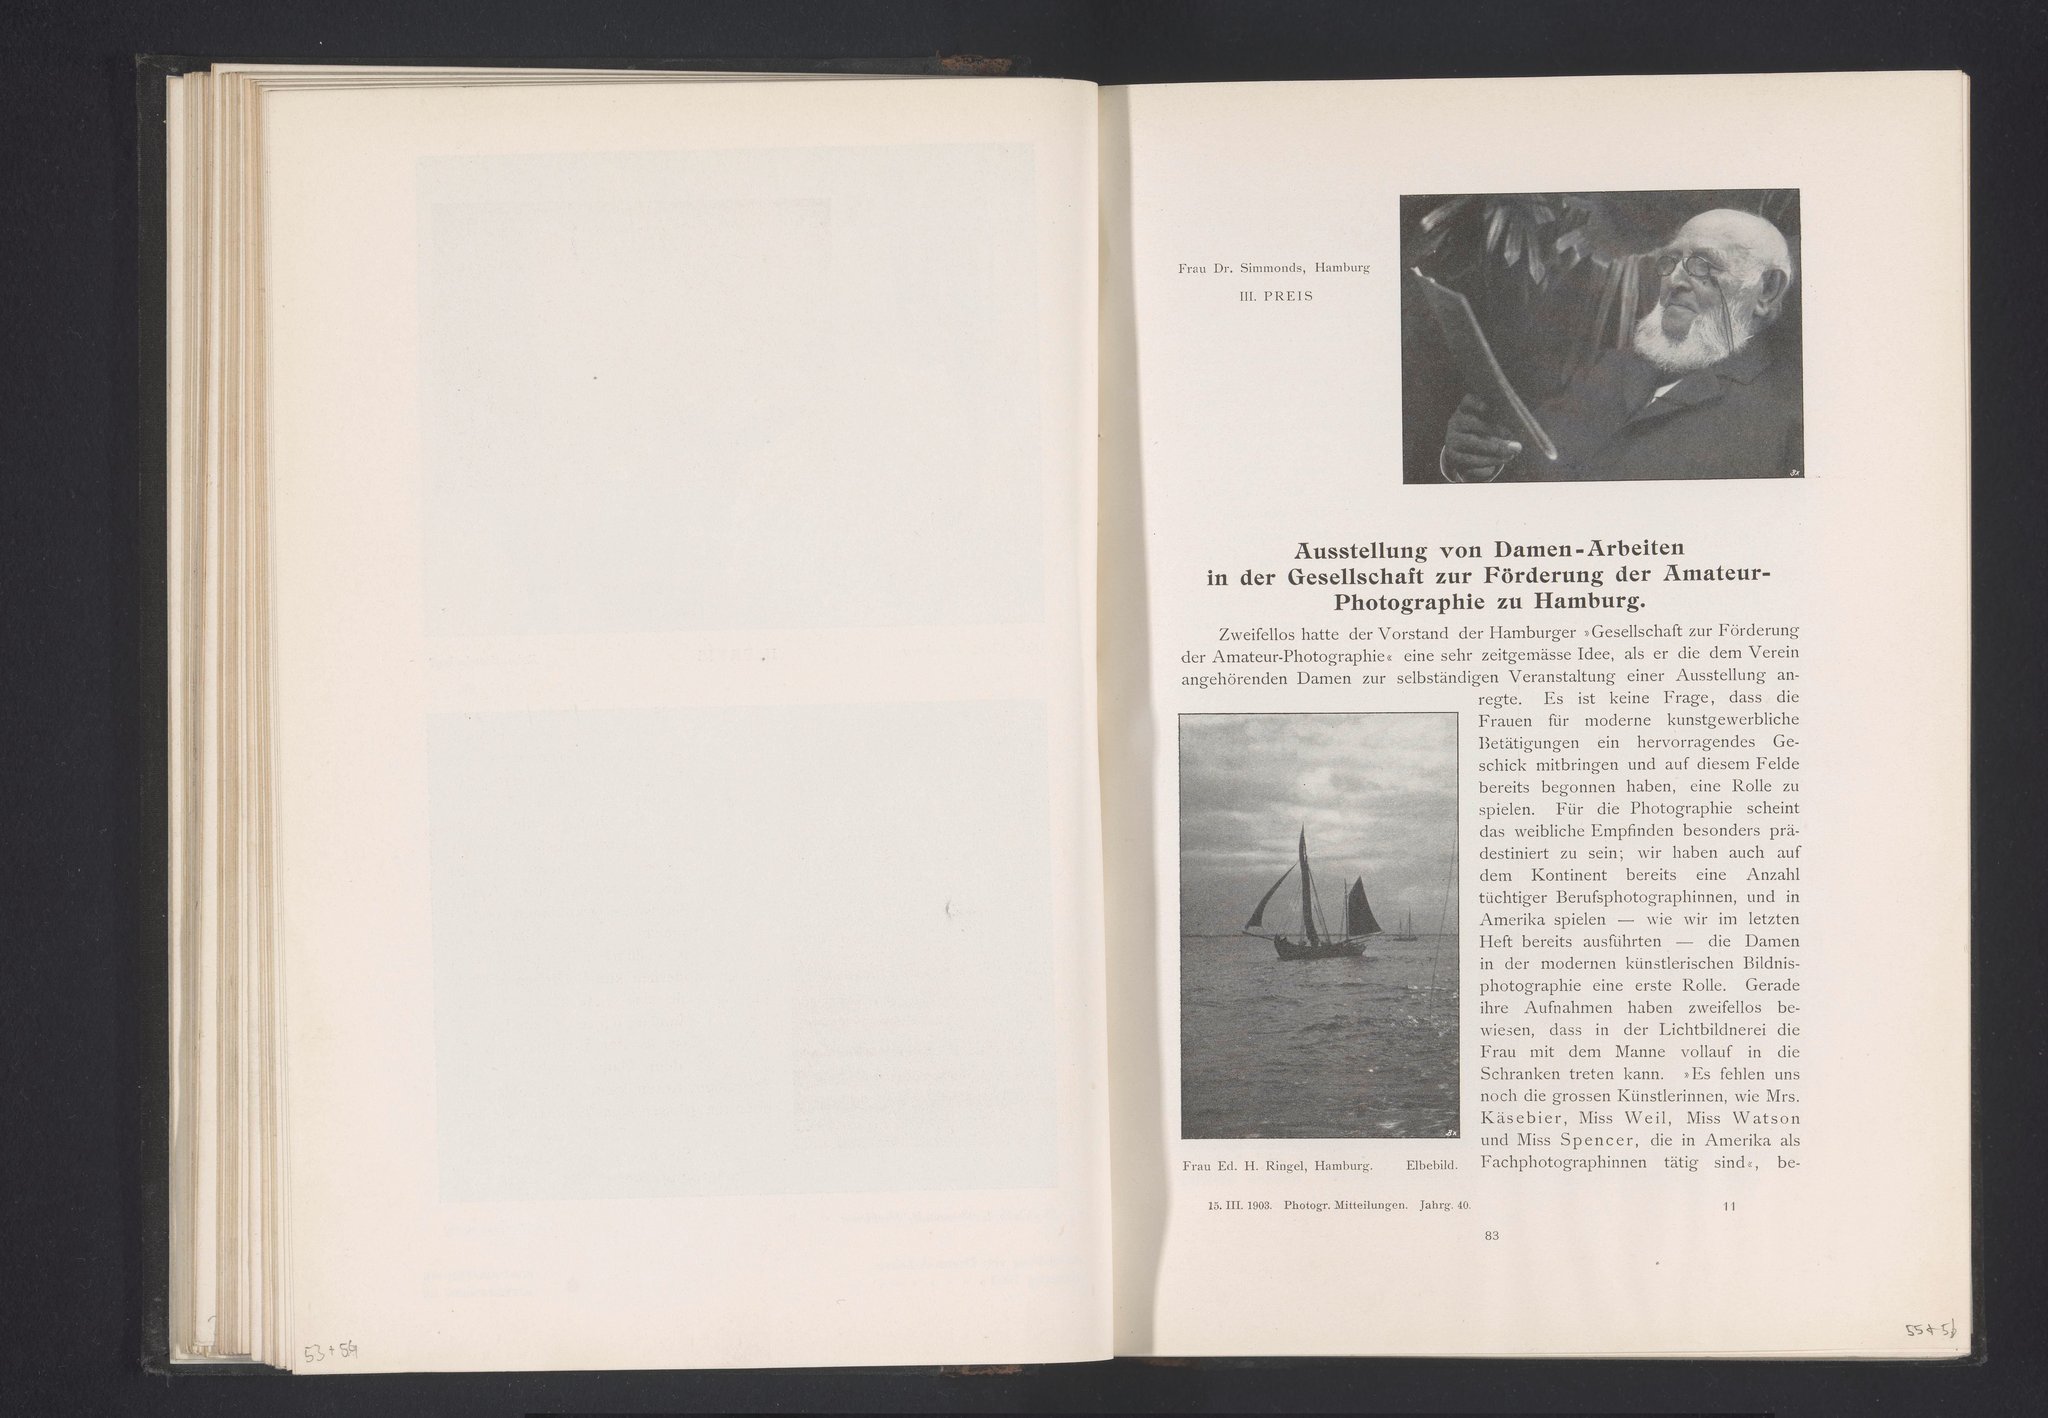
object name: page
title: Portret van een onbekende man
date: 1898-1903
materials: paper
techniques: autotype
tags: historical persons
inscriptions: inscription: ‘III. Preis’, name: ‘Frau Dr. Simmonds’, monogram: ‘BX’, inscription: ‘Hamburg’